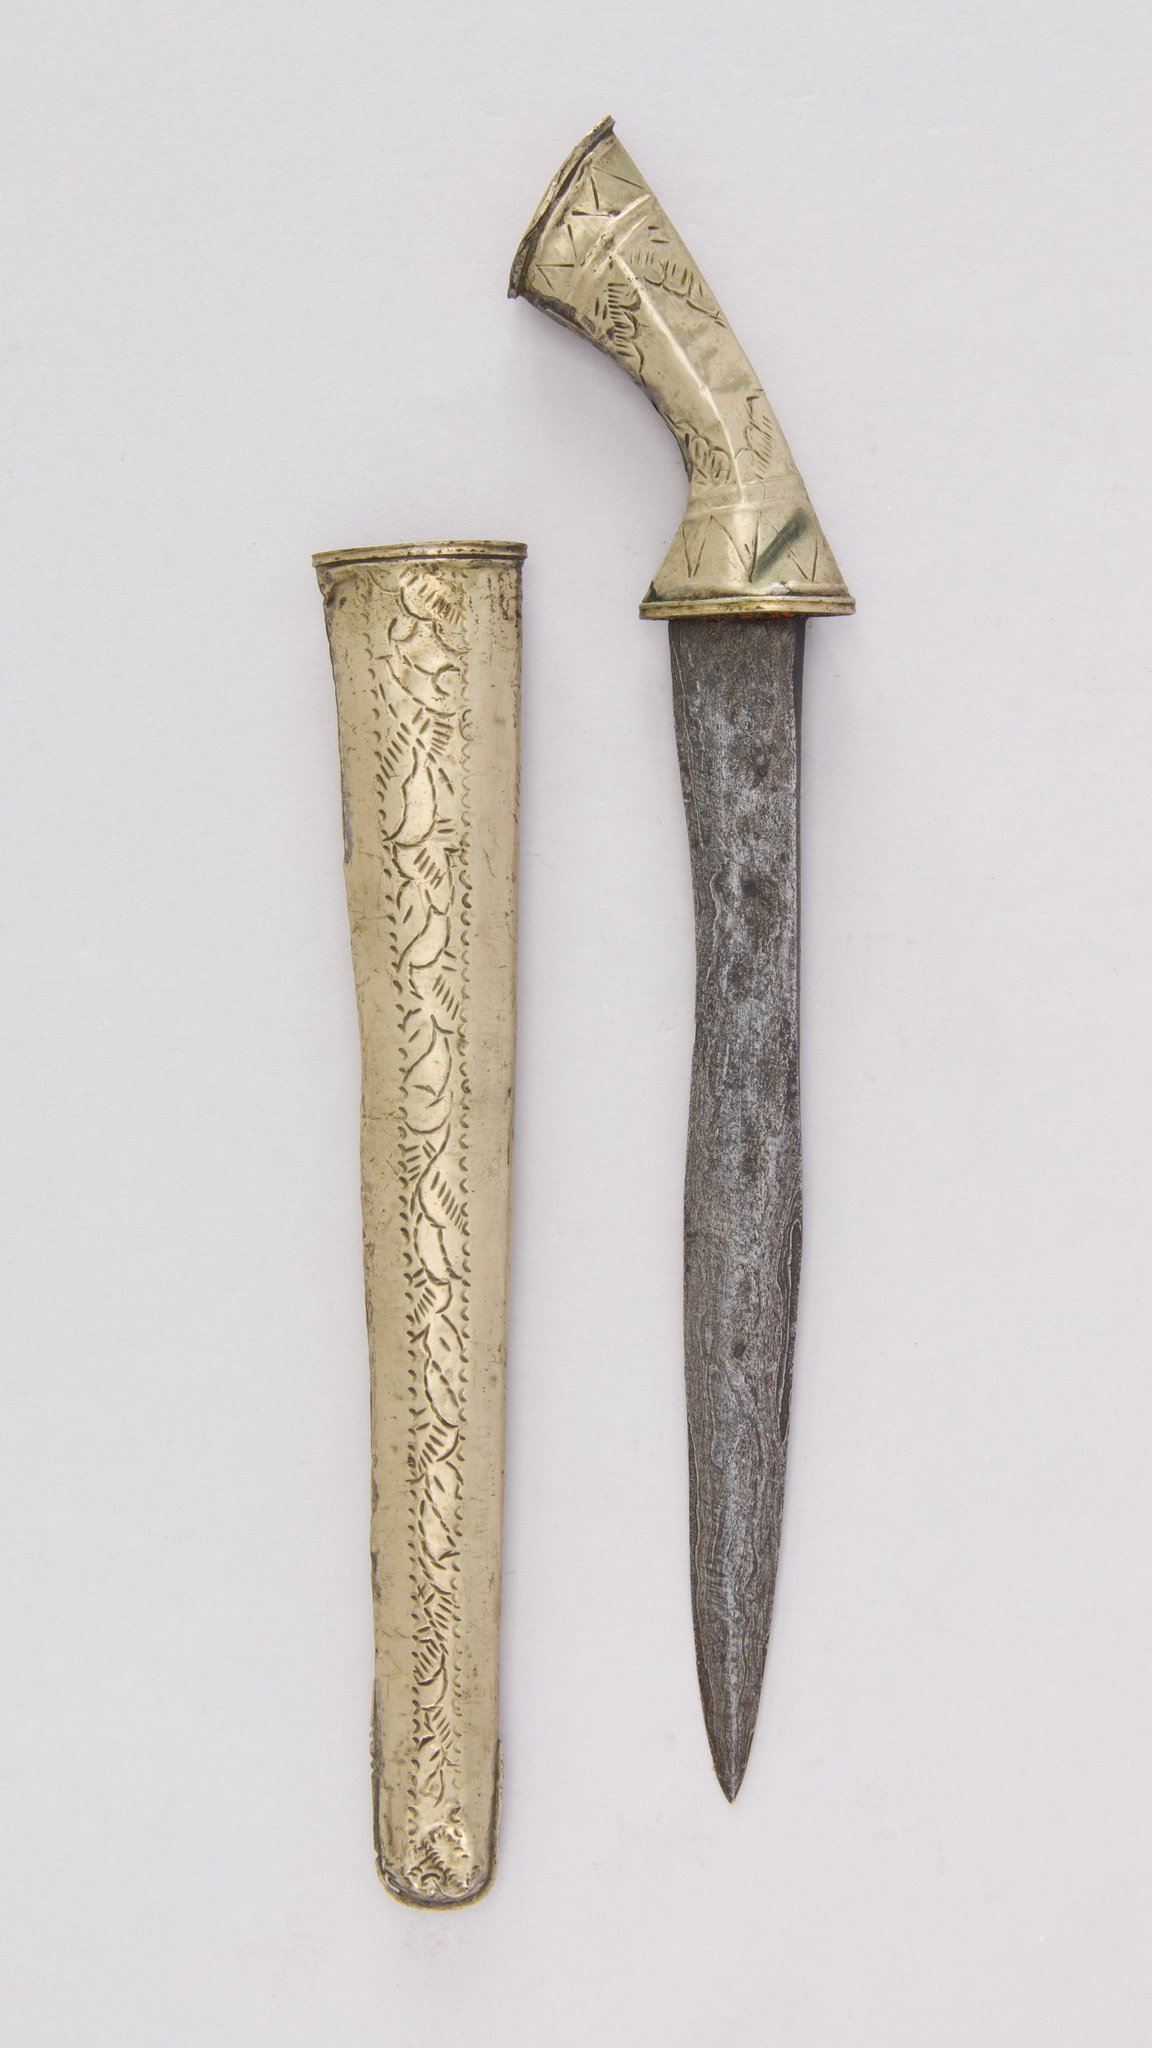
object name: knife with sheath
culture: javanese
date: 1501-1900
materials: metal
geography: indonesia